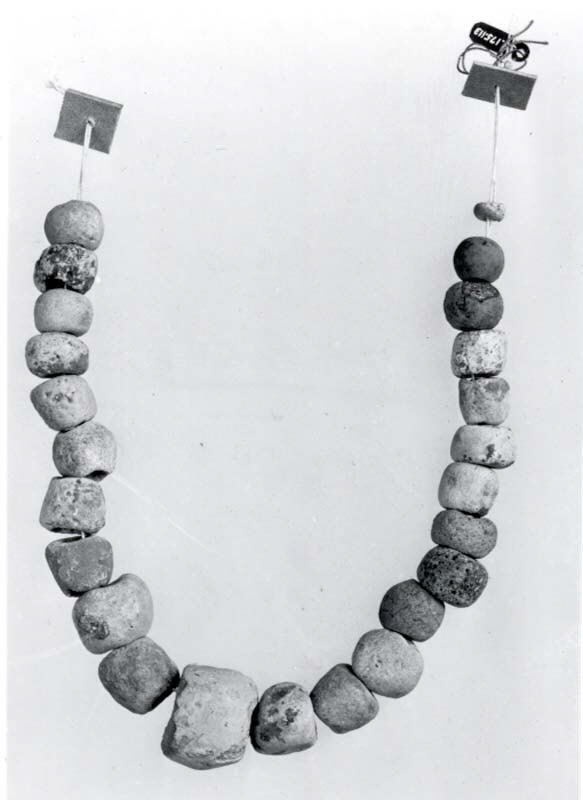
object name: bead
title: Beads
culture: sasanian or islamic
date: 501-800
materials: ceramic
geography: iran